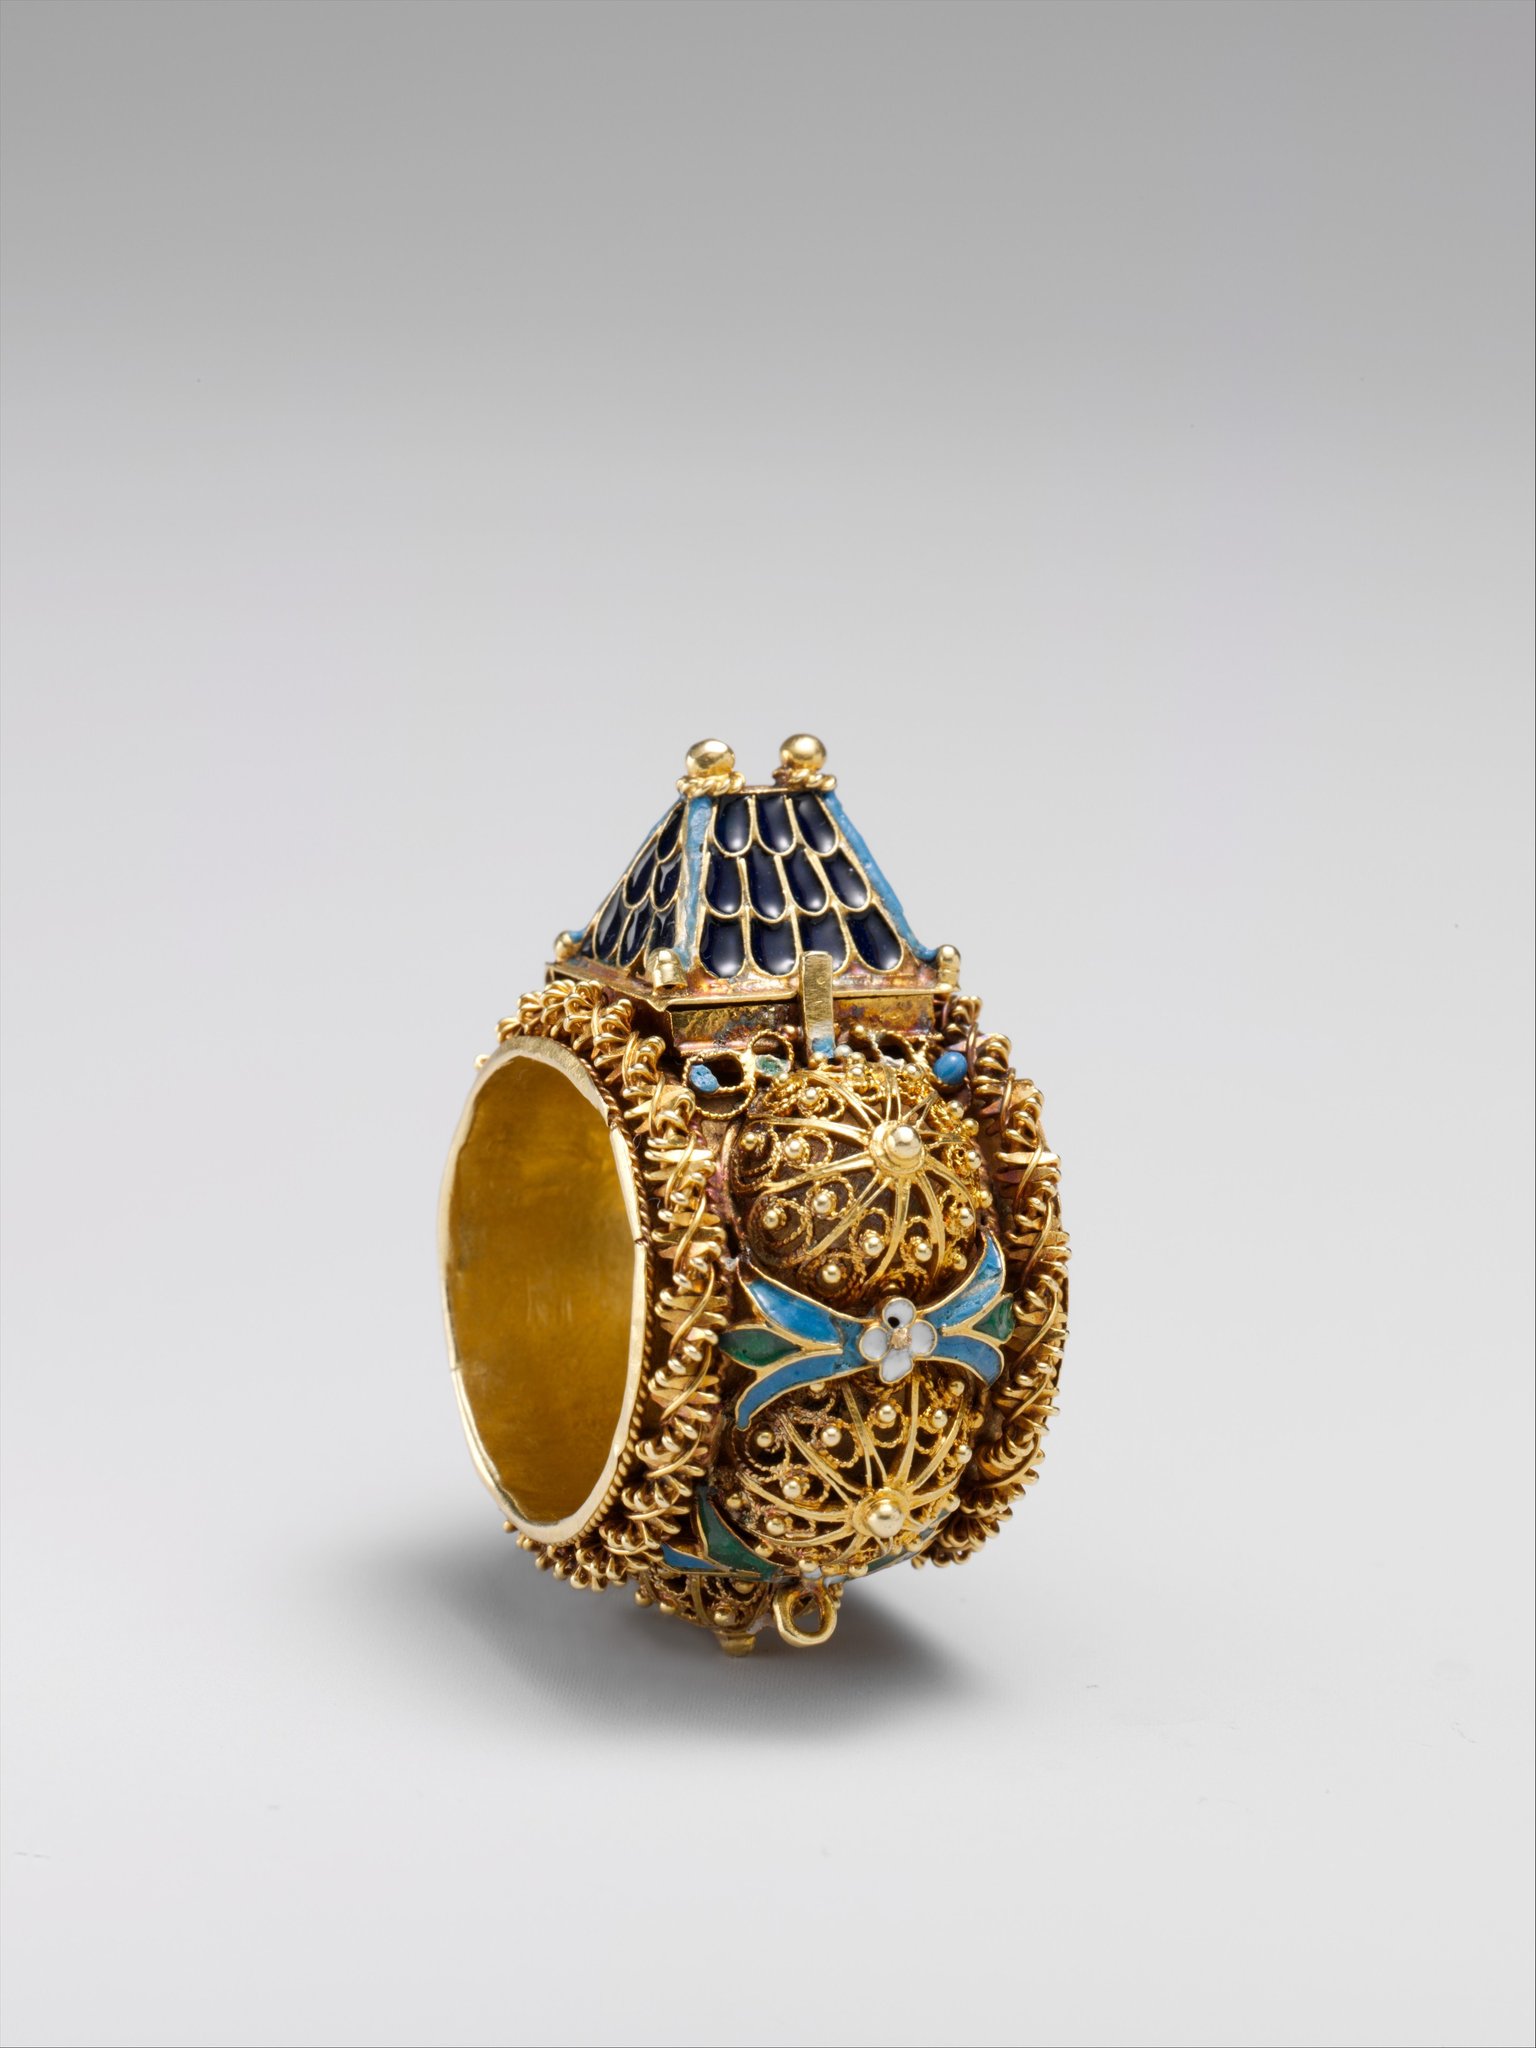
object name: ring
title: Jewish betrothal ring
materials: enamel, gold